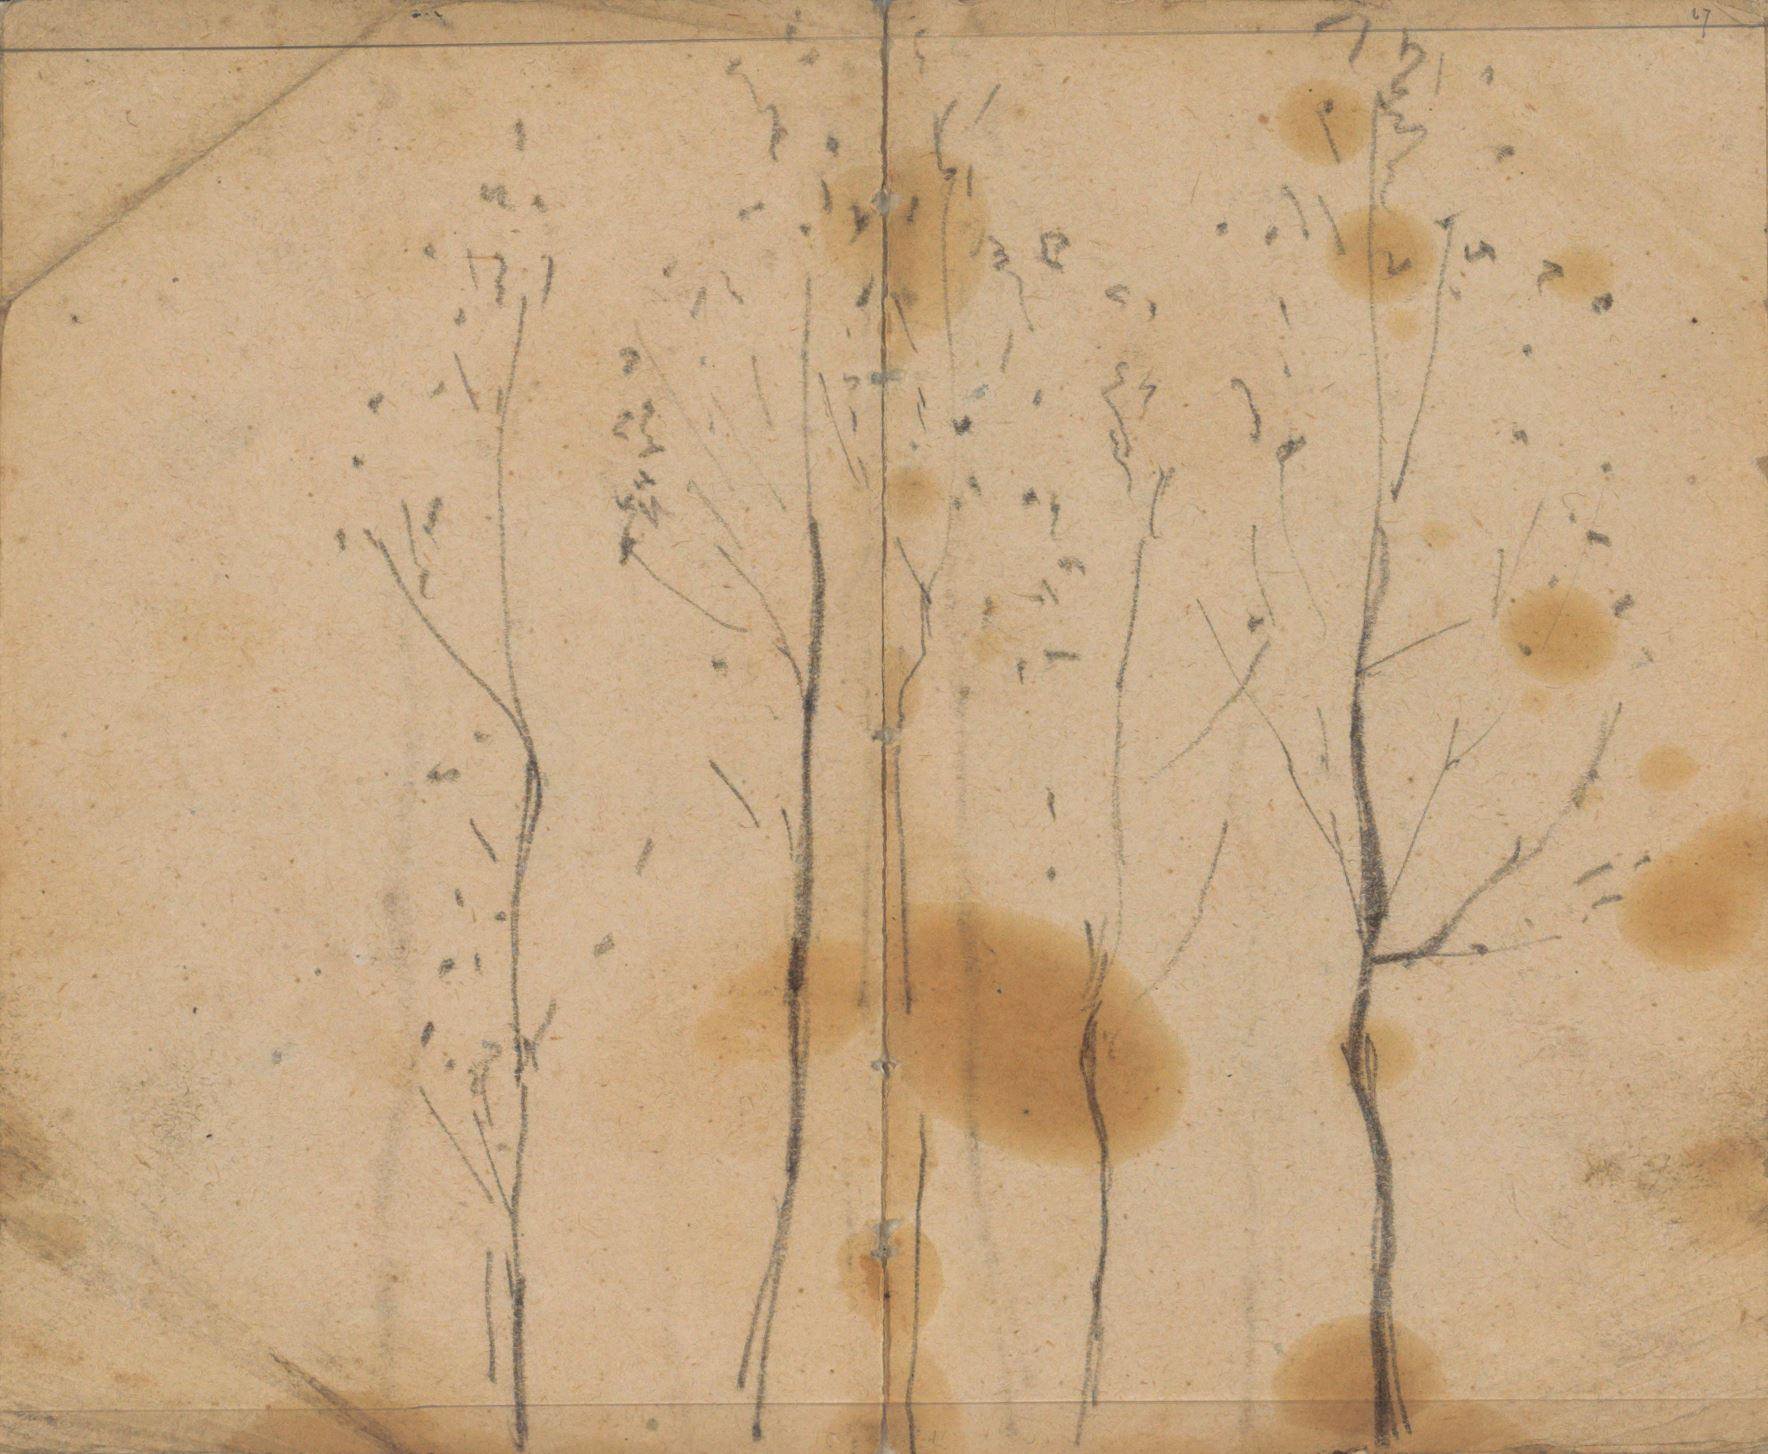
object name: sketchbook leaf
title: Vijf bomen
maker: george hendrik breitner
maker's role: draughtsman, painter, print maker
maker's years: 1857-1923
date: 1881-1883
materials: chalk, paper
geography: south holland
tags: trees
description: Vijf bomen. Pagina 16 en pagina 17 uit een schetsboek met 43 bladen.